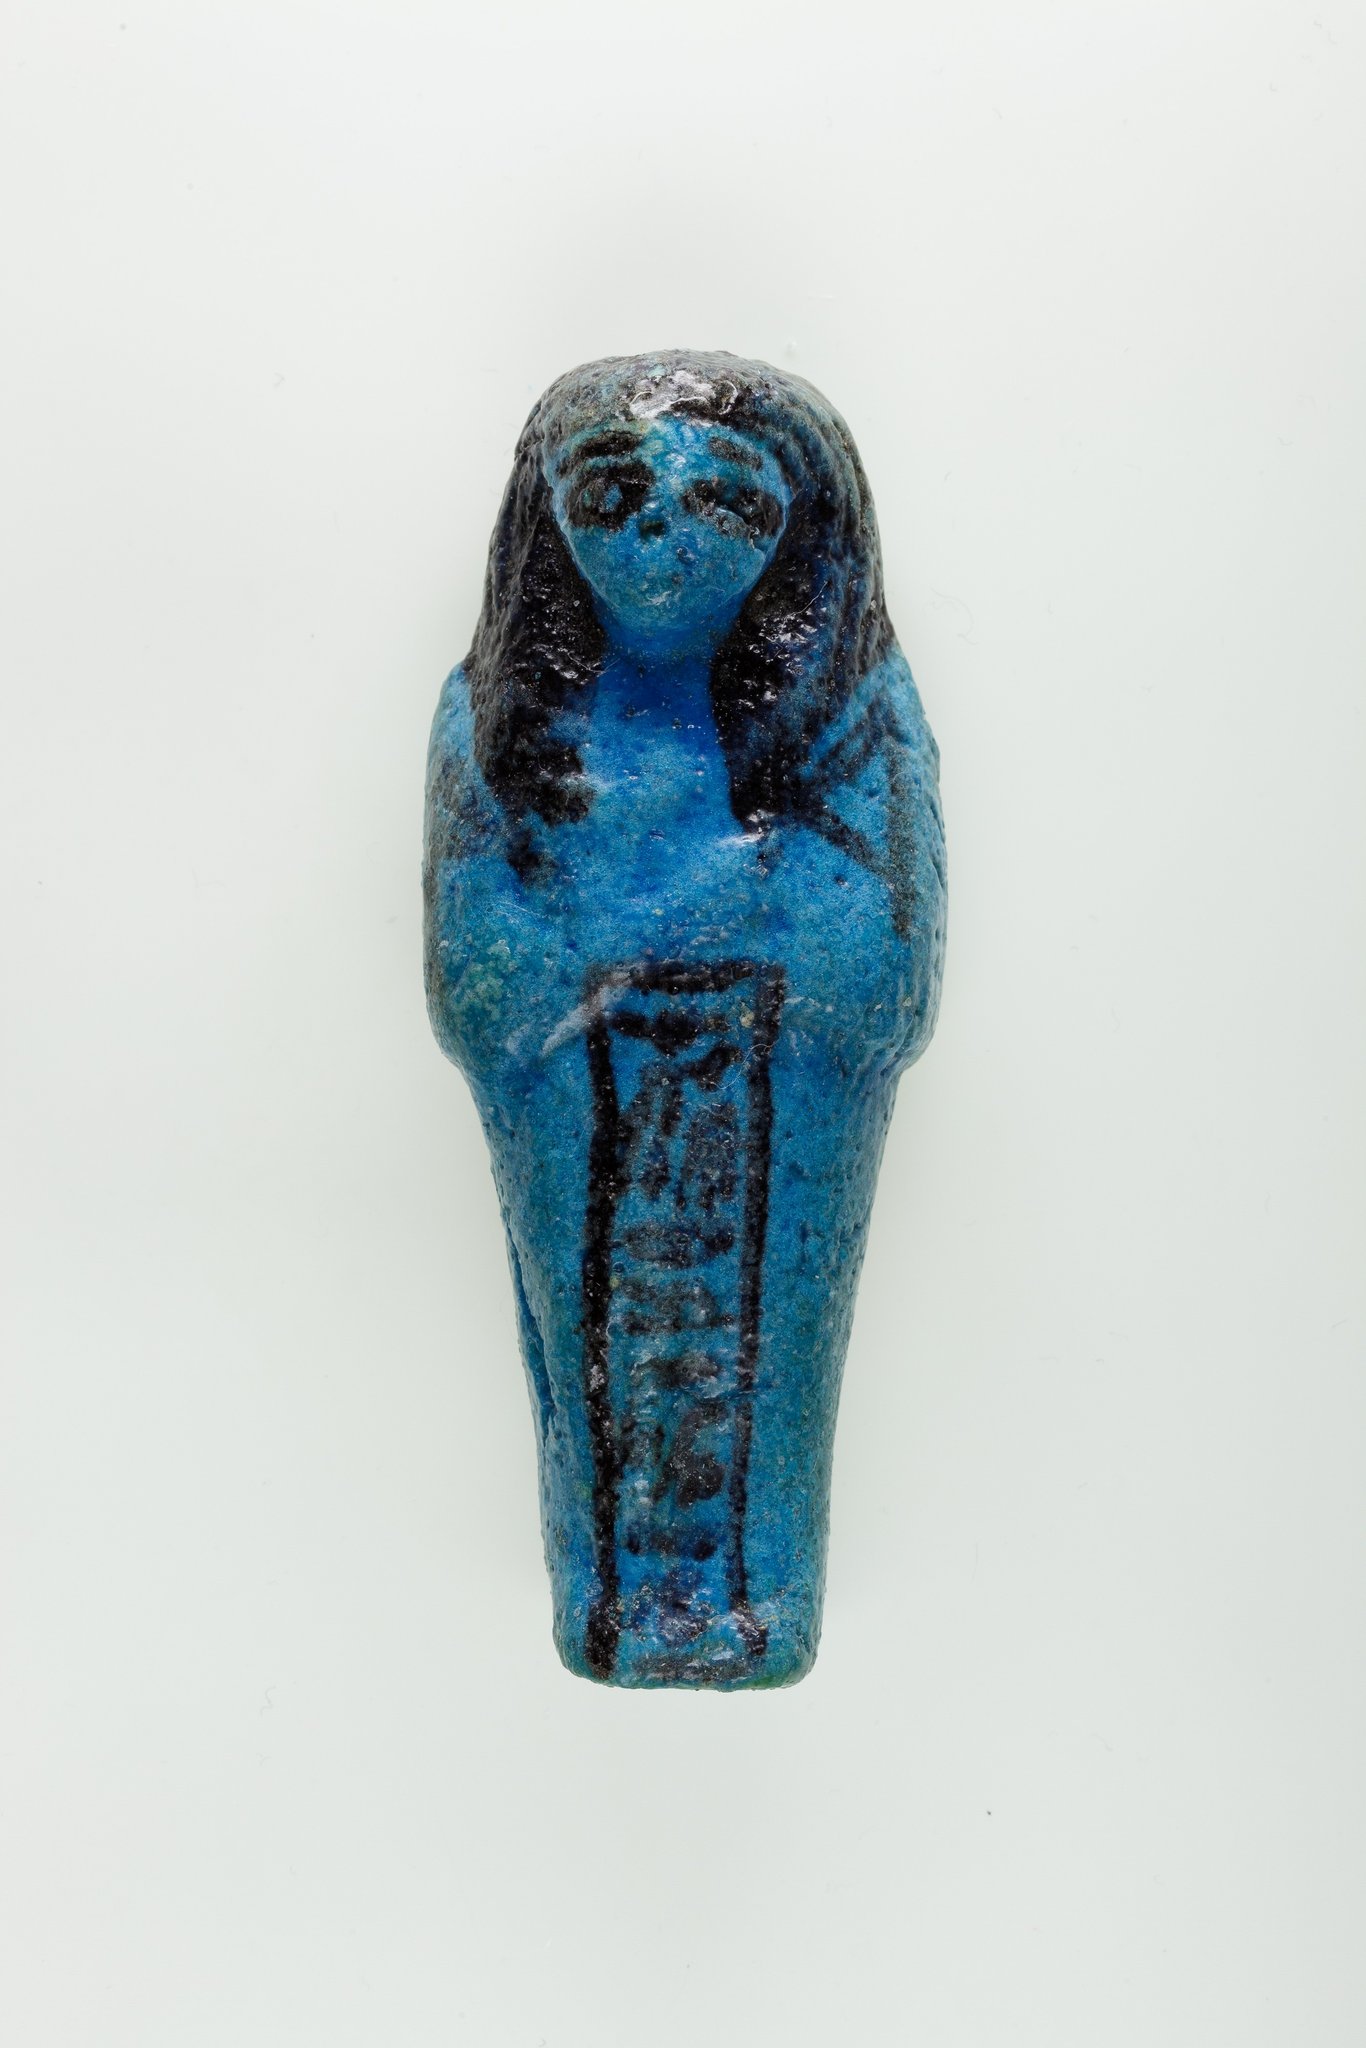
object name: shabti, worker, nauny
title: Worker Shabti of Nauny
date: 1050 BCE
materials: faience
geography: egypt